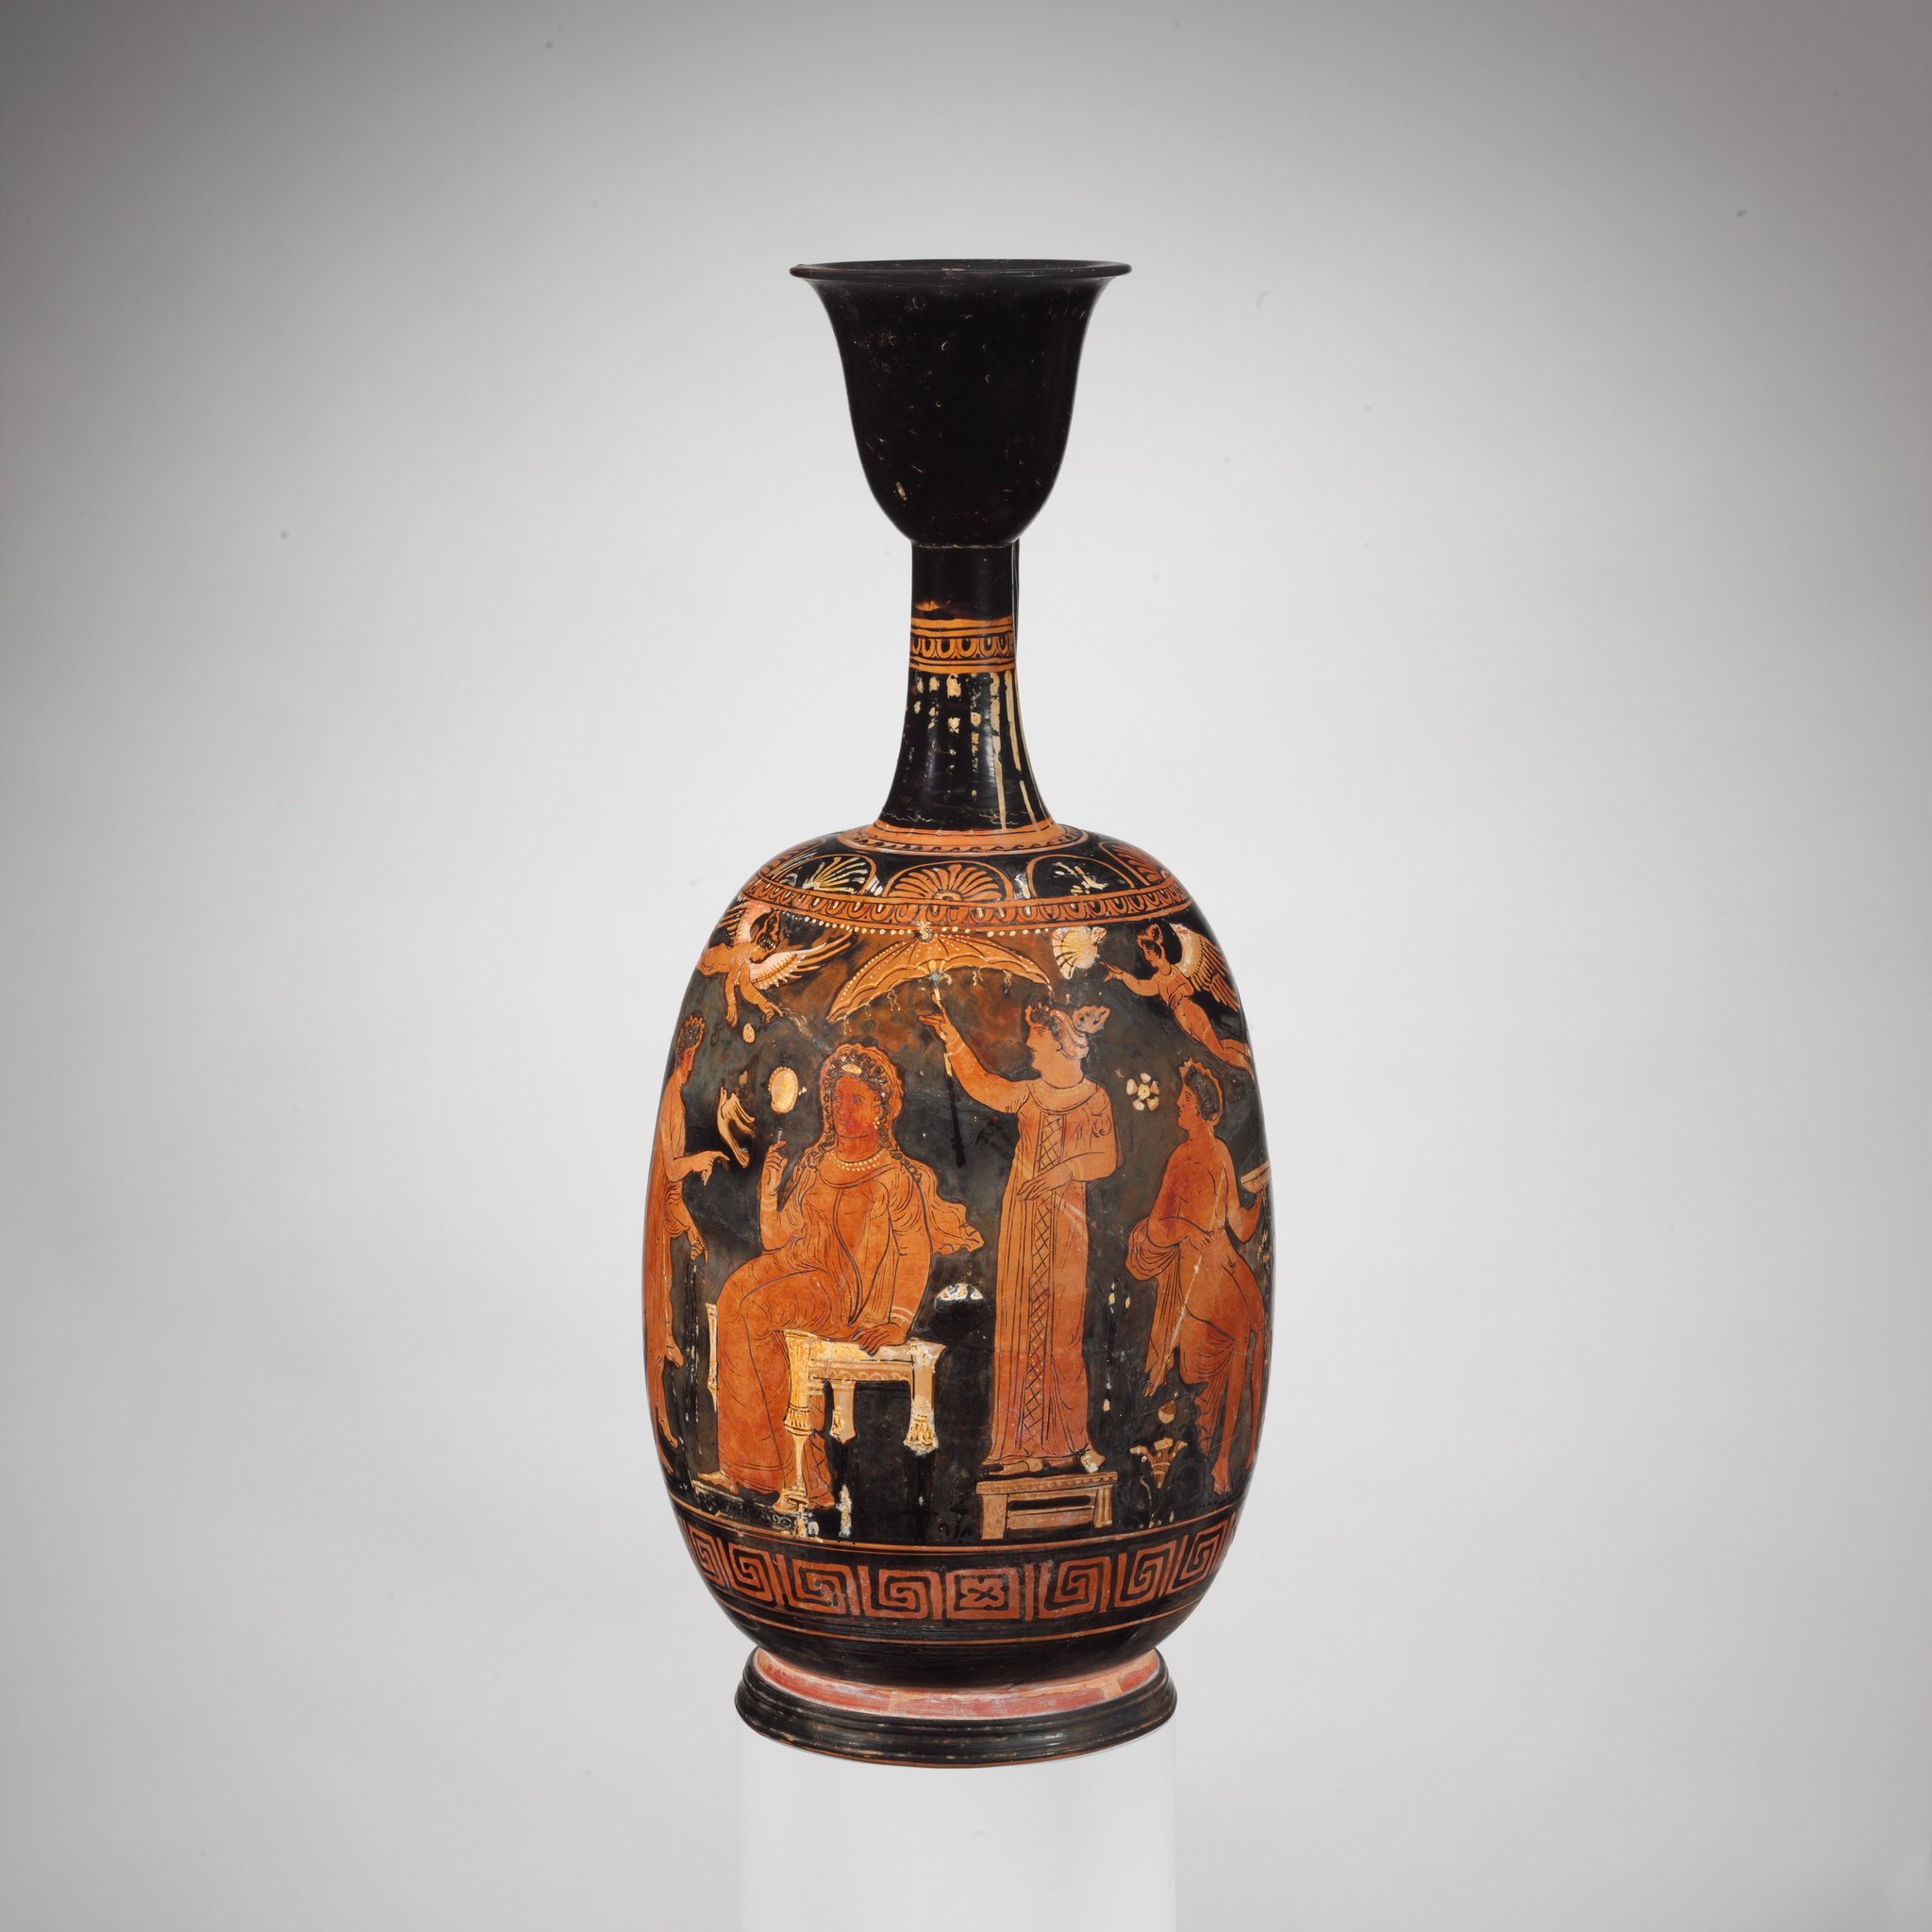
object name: squat lekythos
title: Terracotta squat lekythos (oil flask)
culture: greek, south italian, apulian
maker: group of new york 28.57.10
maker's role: artist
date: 340-320 BCE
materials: terracotta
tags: women,eros